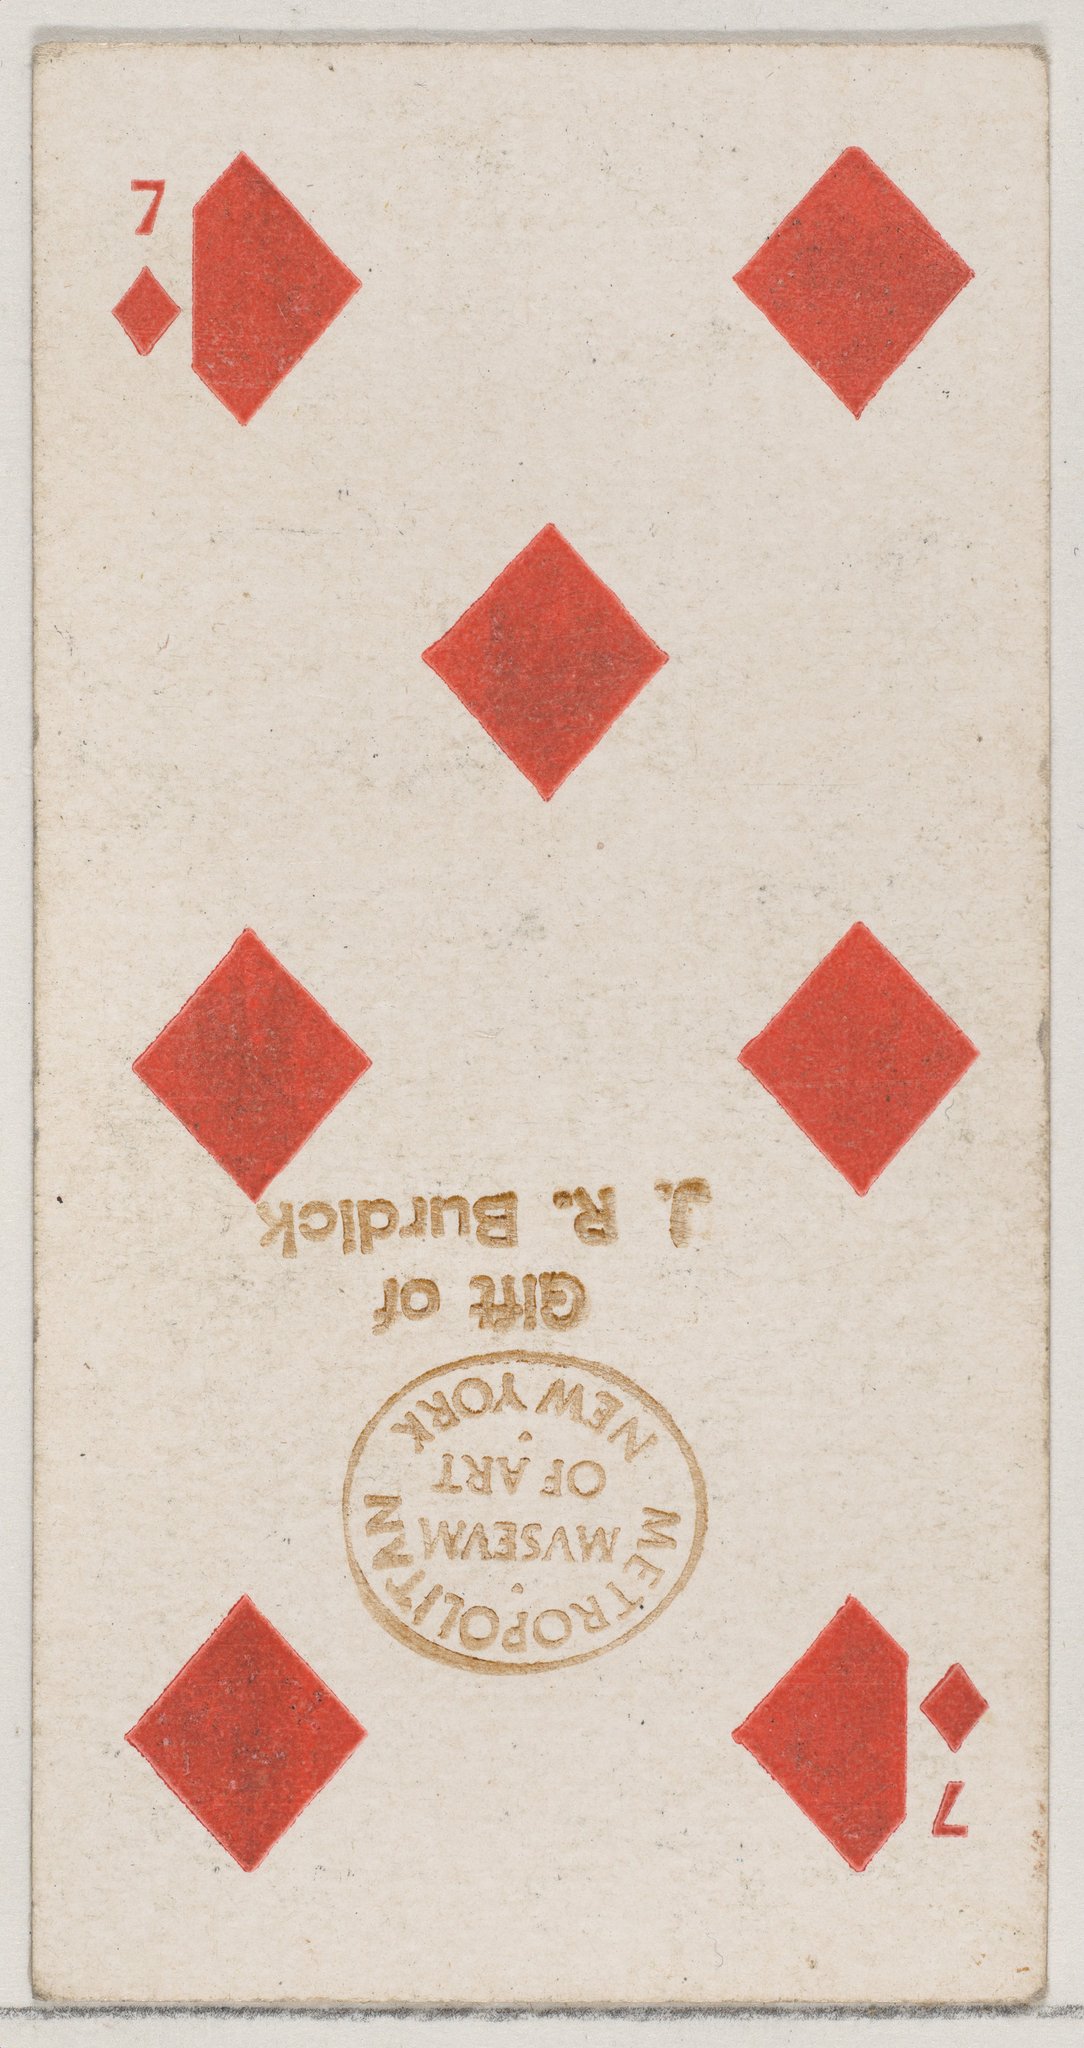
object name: print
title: Seven Diamonds (red), from the Playing Cards series (N84) for Duke brand cigarettes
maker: w. duke, sons & co.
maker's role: publisher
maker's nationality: american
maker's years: 1870-1920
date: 1888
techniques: color lithograph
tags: playing cards